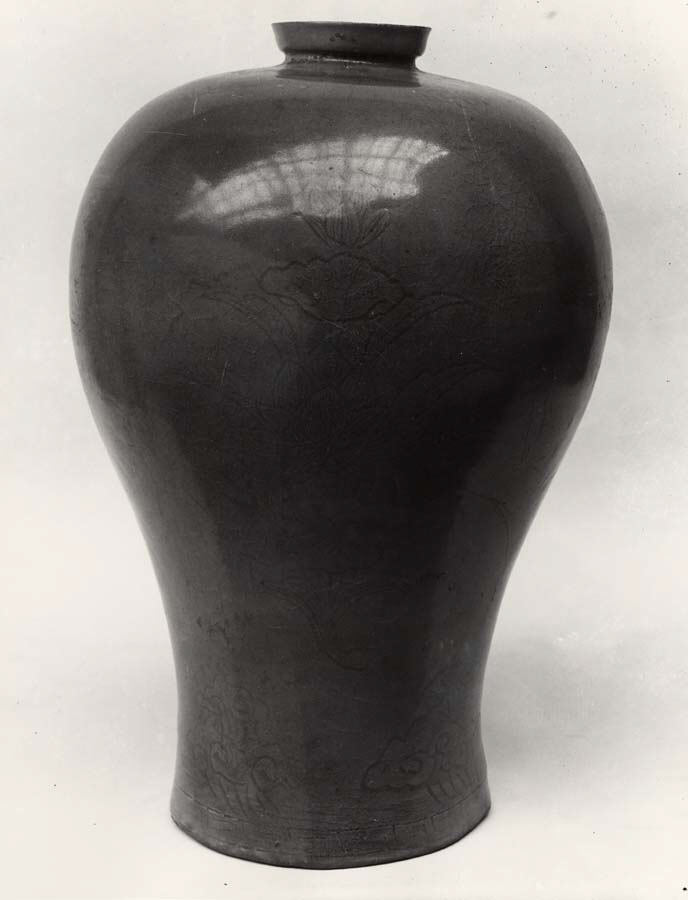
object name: jar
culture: korean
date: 1101-1200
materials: ceramic glaze, glaze, stoneware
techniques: incising